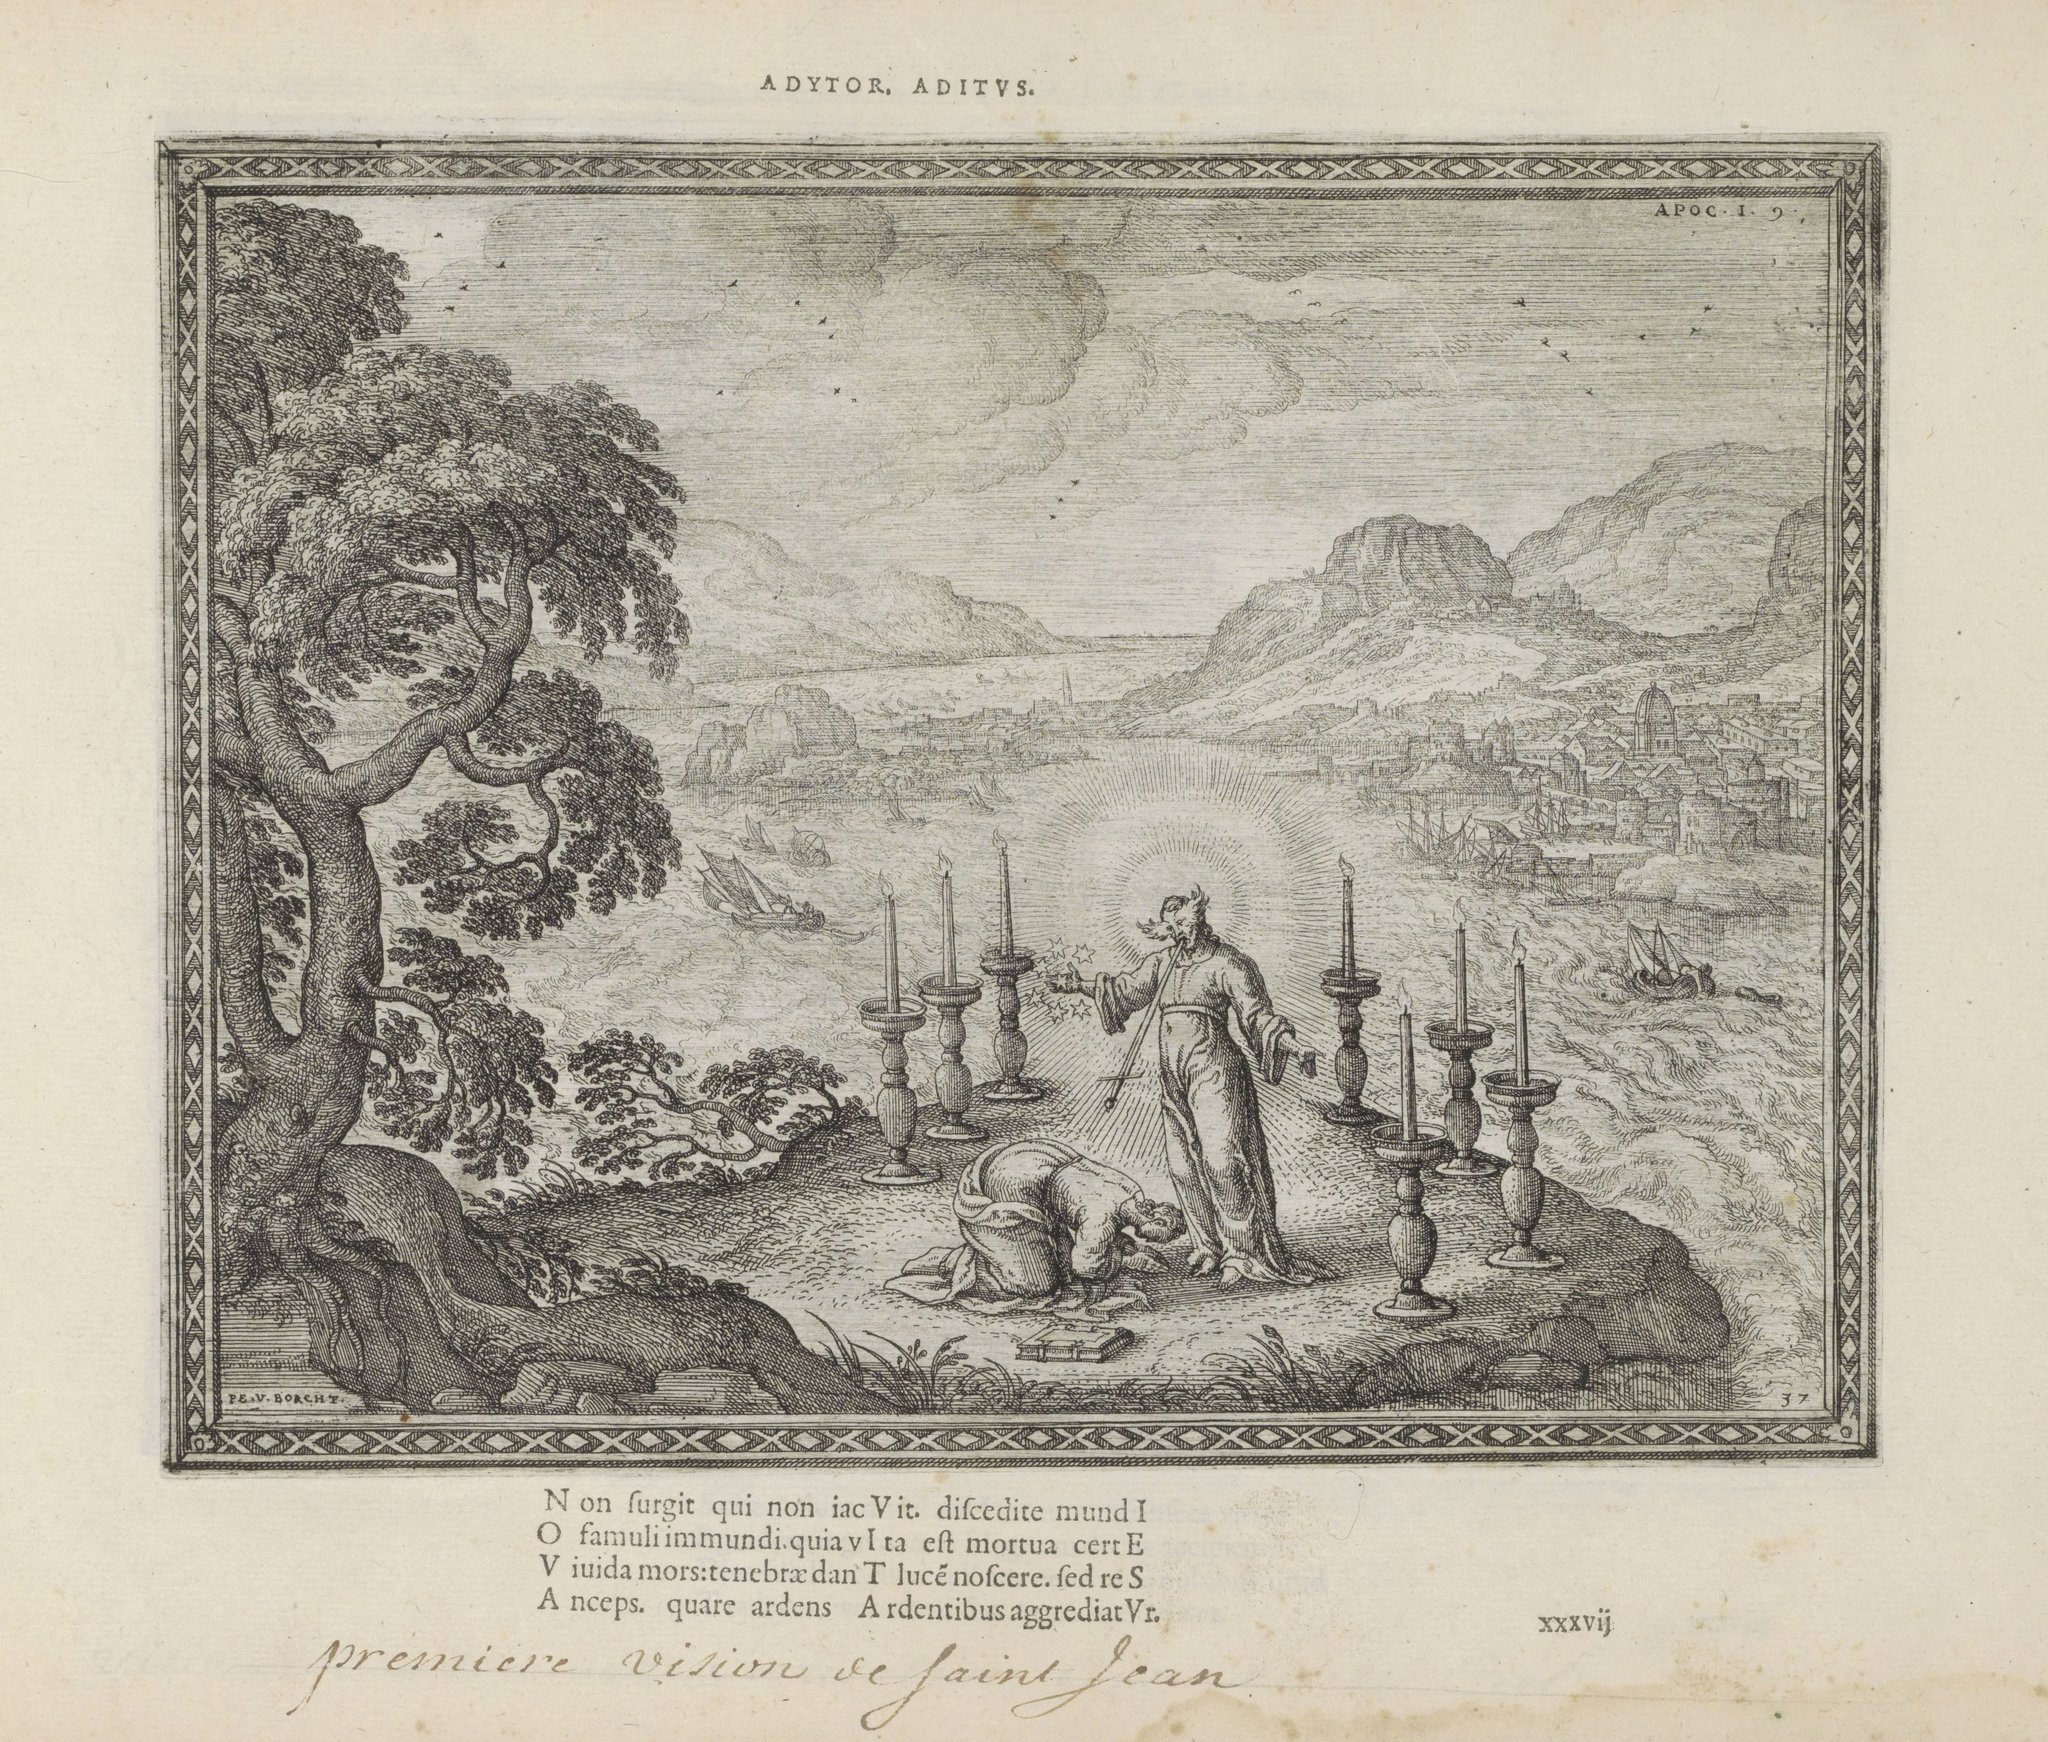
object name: print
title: Emblemata Sacra è praecipuis utriusque testamenti historiis concinnata (Nieuwe Testament)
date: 1582-1593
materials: paper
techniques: etching, letterpress printing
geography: antwerp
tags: gulf, bay, city-view, and landscape with man-made constructions, christ between seven golden candlesticks appears to john, who falls to the ground; a sword comes out of christ's mouth and he holds seven stars in his hands, river mouth, estuary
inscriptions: inscription: ‘Premier vision de saint Jean’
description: Landschap met een riviermonding, zeilschepen en links een boom. Op de voorgrond het visioen van de zeven kandelaars. Te midden van zeven altaarkandelaren staat een man met vlammende ogen, zeven sterren in zijn rechterhand. Uit zijn mond komt een zwaard. Johannes knielt in gebed voor hem. Naast hem ligt een boek (Op. 1). Met een motto in het Latijn boven de voorstelling en een vierregelig onderschrift in het Latijn onder de prent. De prent maakt deel uit van een album.